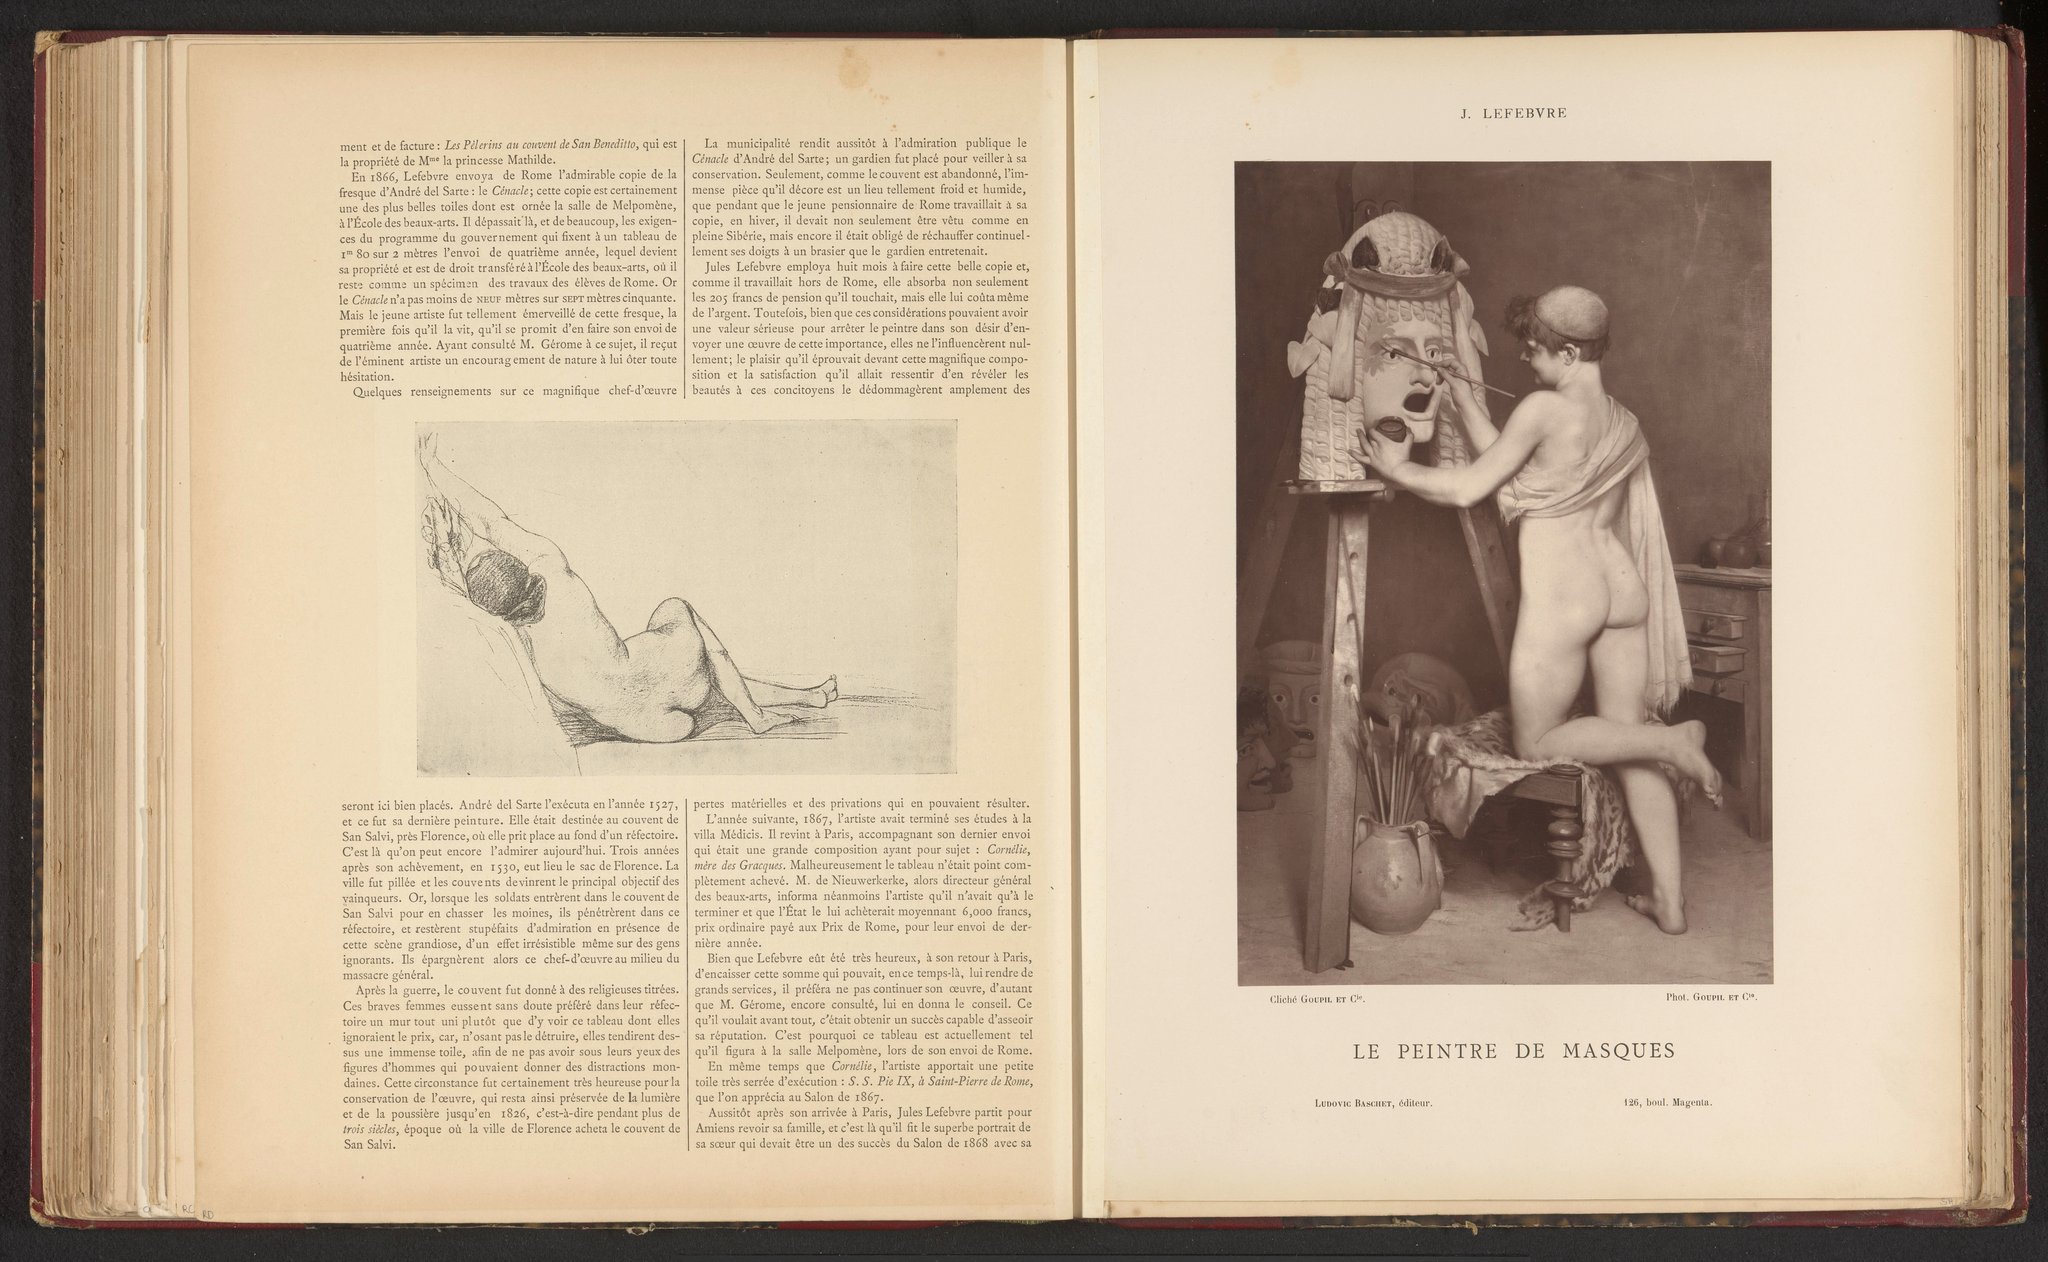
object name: photomechanical print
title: Fotoreproductie van een tekening door vermoedelijk Jules Joseph Lefebvre, voorstellend een liggend naakt op de rug gezien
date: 1876-1879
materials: paper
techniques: autotype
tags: drawing, sketch, the (nude) human figure; 'corpo humano' (ripa)